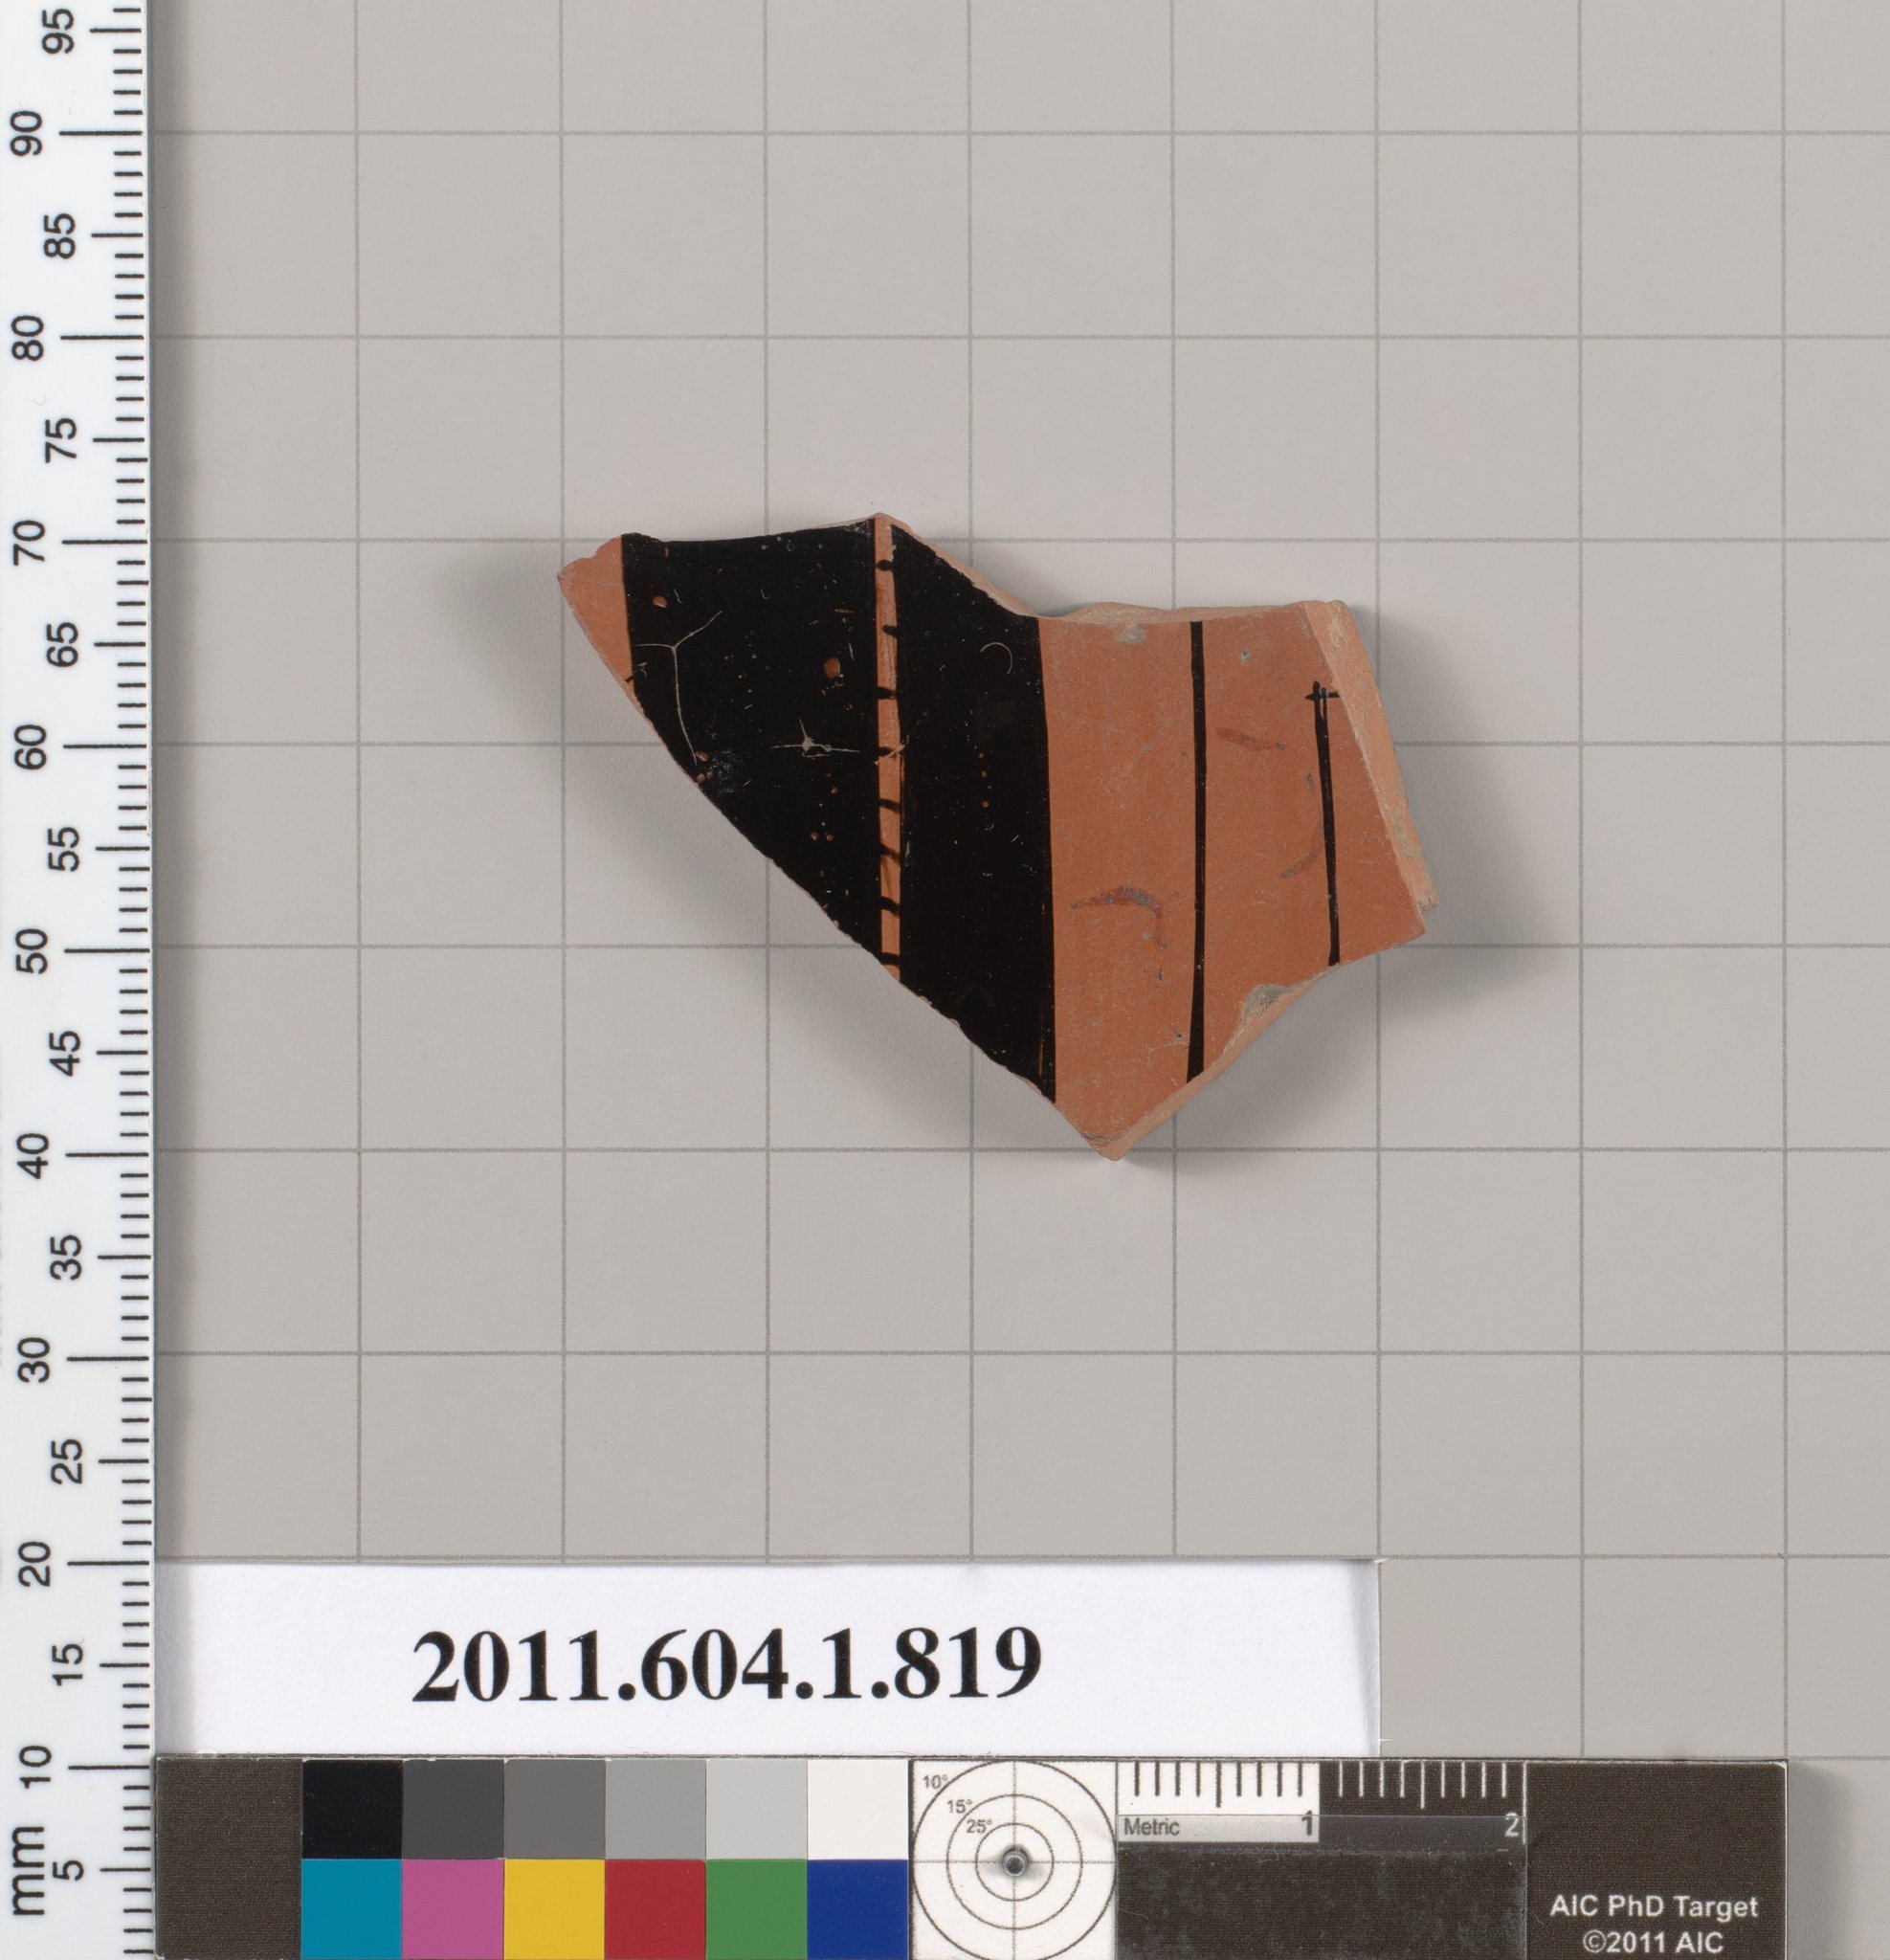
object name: kylix fragment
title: Terracotta fragment of a kylix (drinking cup)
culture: greek, attic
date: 475-451 BCE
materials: terracotta